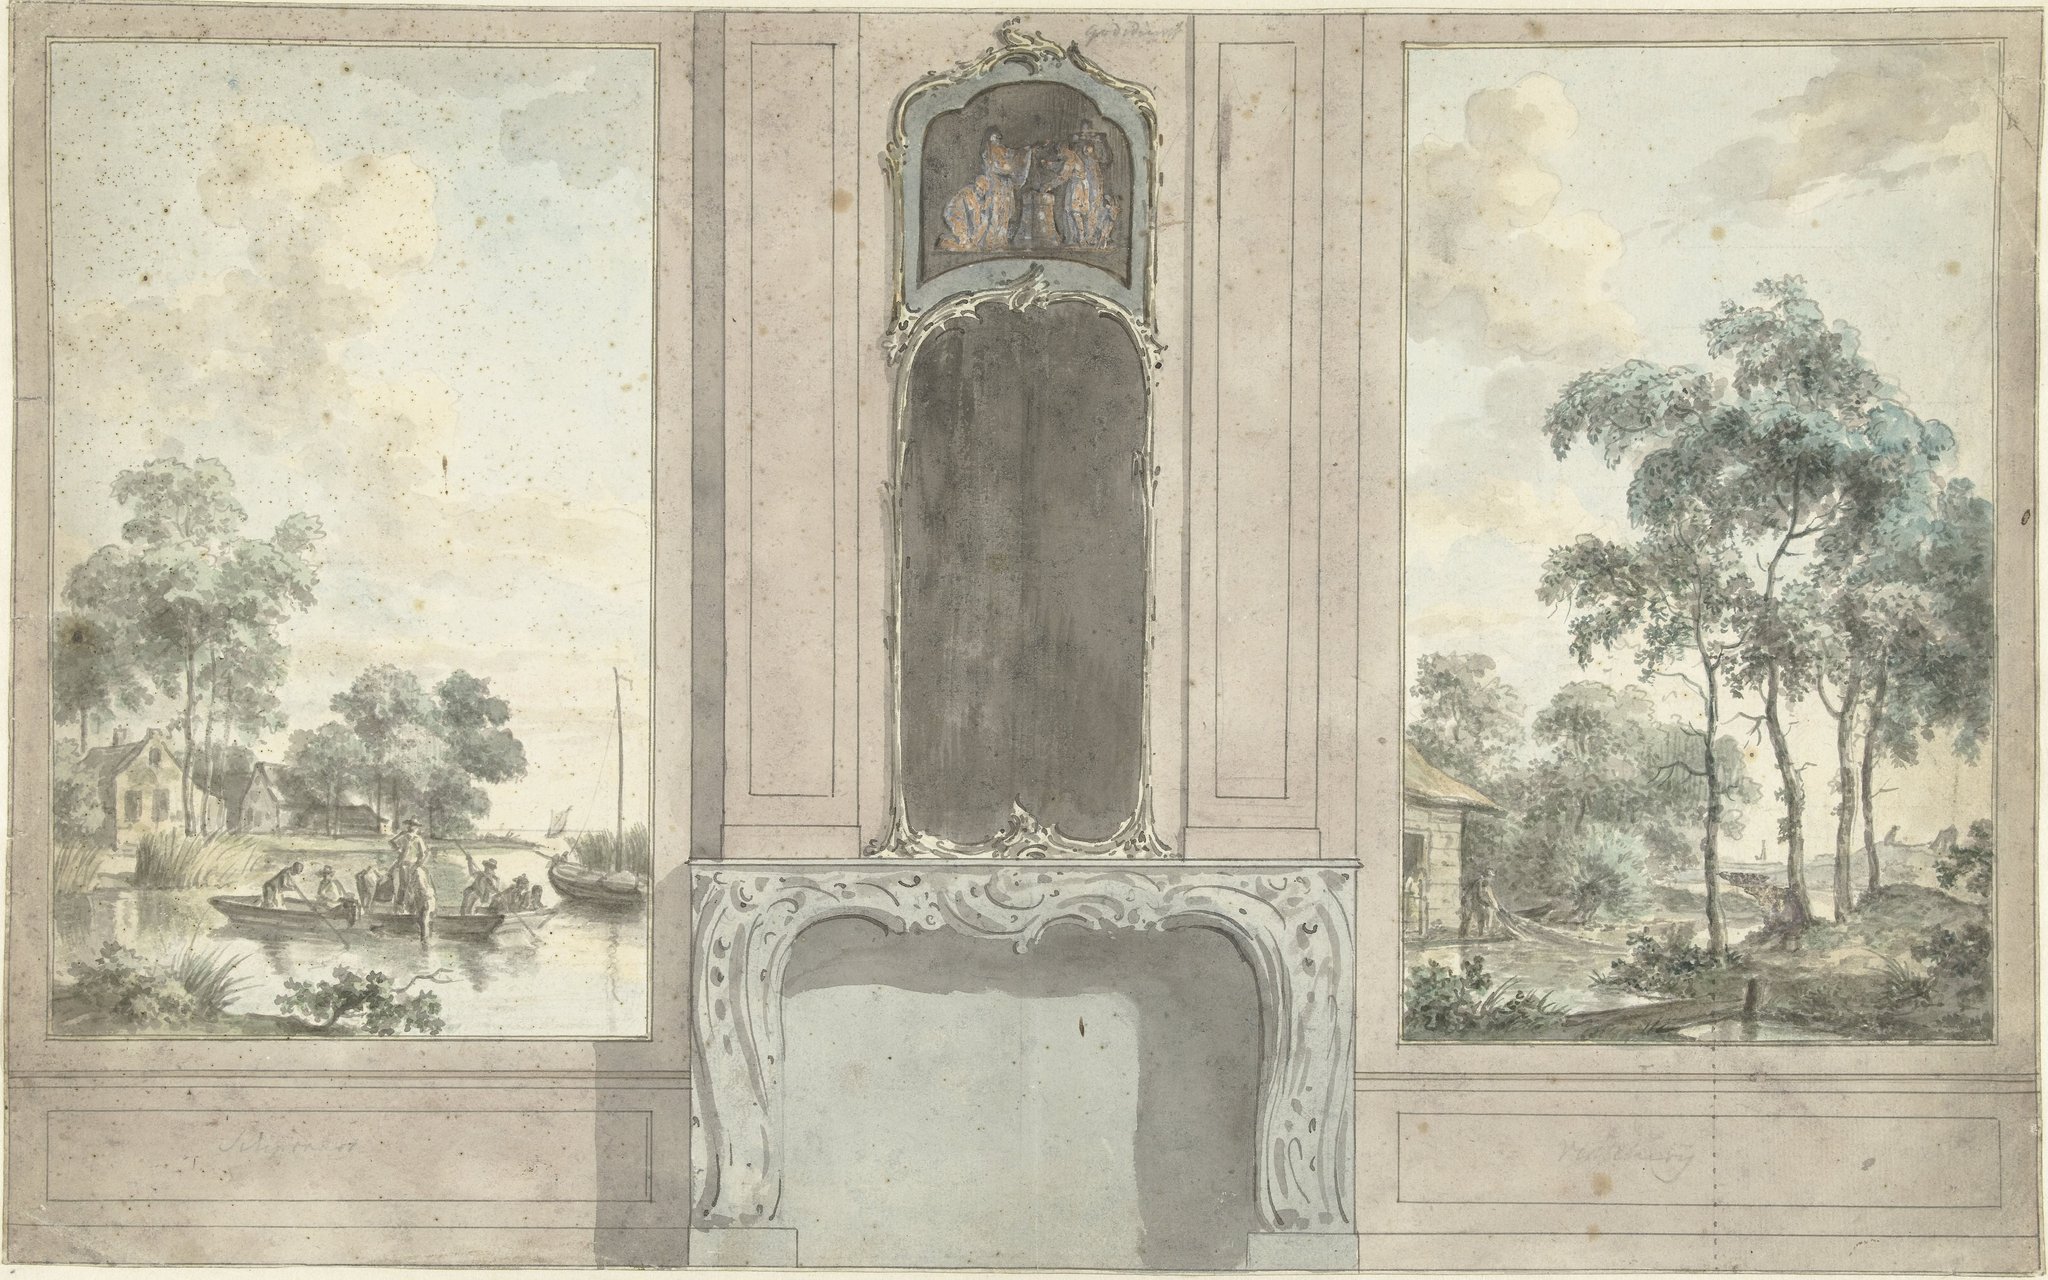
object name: drawing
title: Ontwerp voor een kamerwand met schouw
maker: jurriaan andriessen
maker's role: draughtsman, painter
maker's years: 1742-1819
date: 1752-1819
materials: ink, paper, pencil, watercolor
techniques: brush, pen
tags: wall-covering, sea and coastal fishery